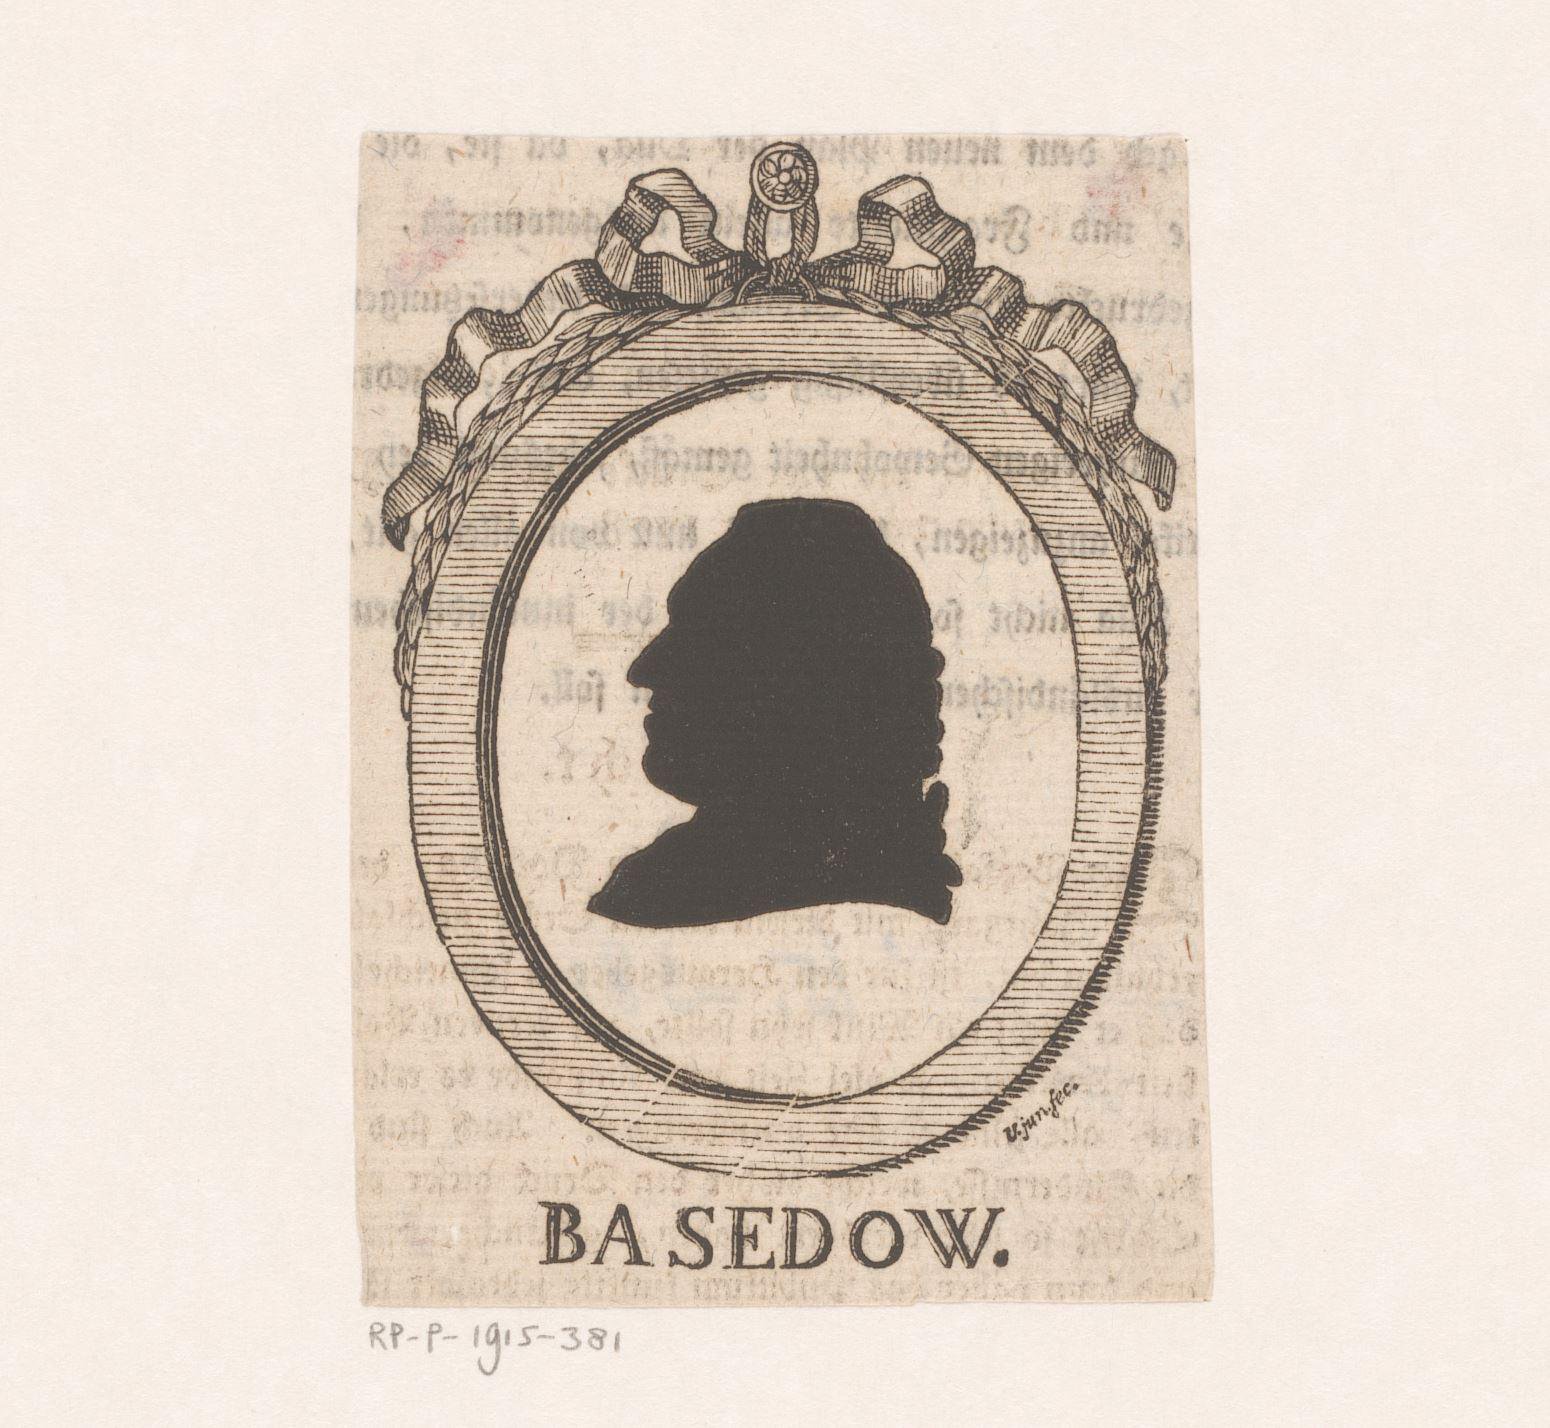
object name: book illustration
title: Silhouetportret van de heer Basedow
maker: johann friedrich gottlieb unger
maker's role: print maker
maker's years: 1753-1804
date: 1778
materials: paper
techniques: engraving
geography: germany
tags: historical persons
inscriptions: collector's mark: Lugt 2228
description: Prent afkomstig uit de publicatie: Olla Potrida. Berlijn: Weverschen Buchhandlung, 1778.